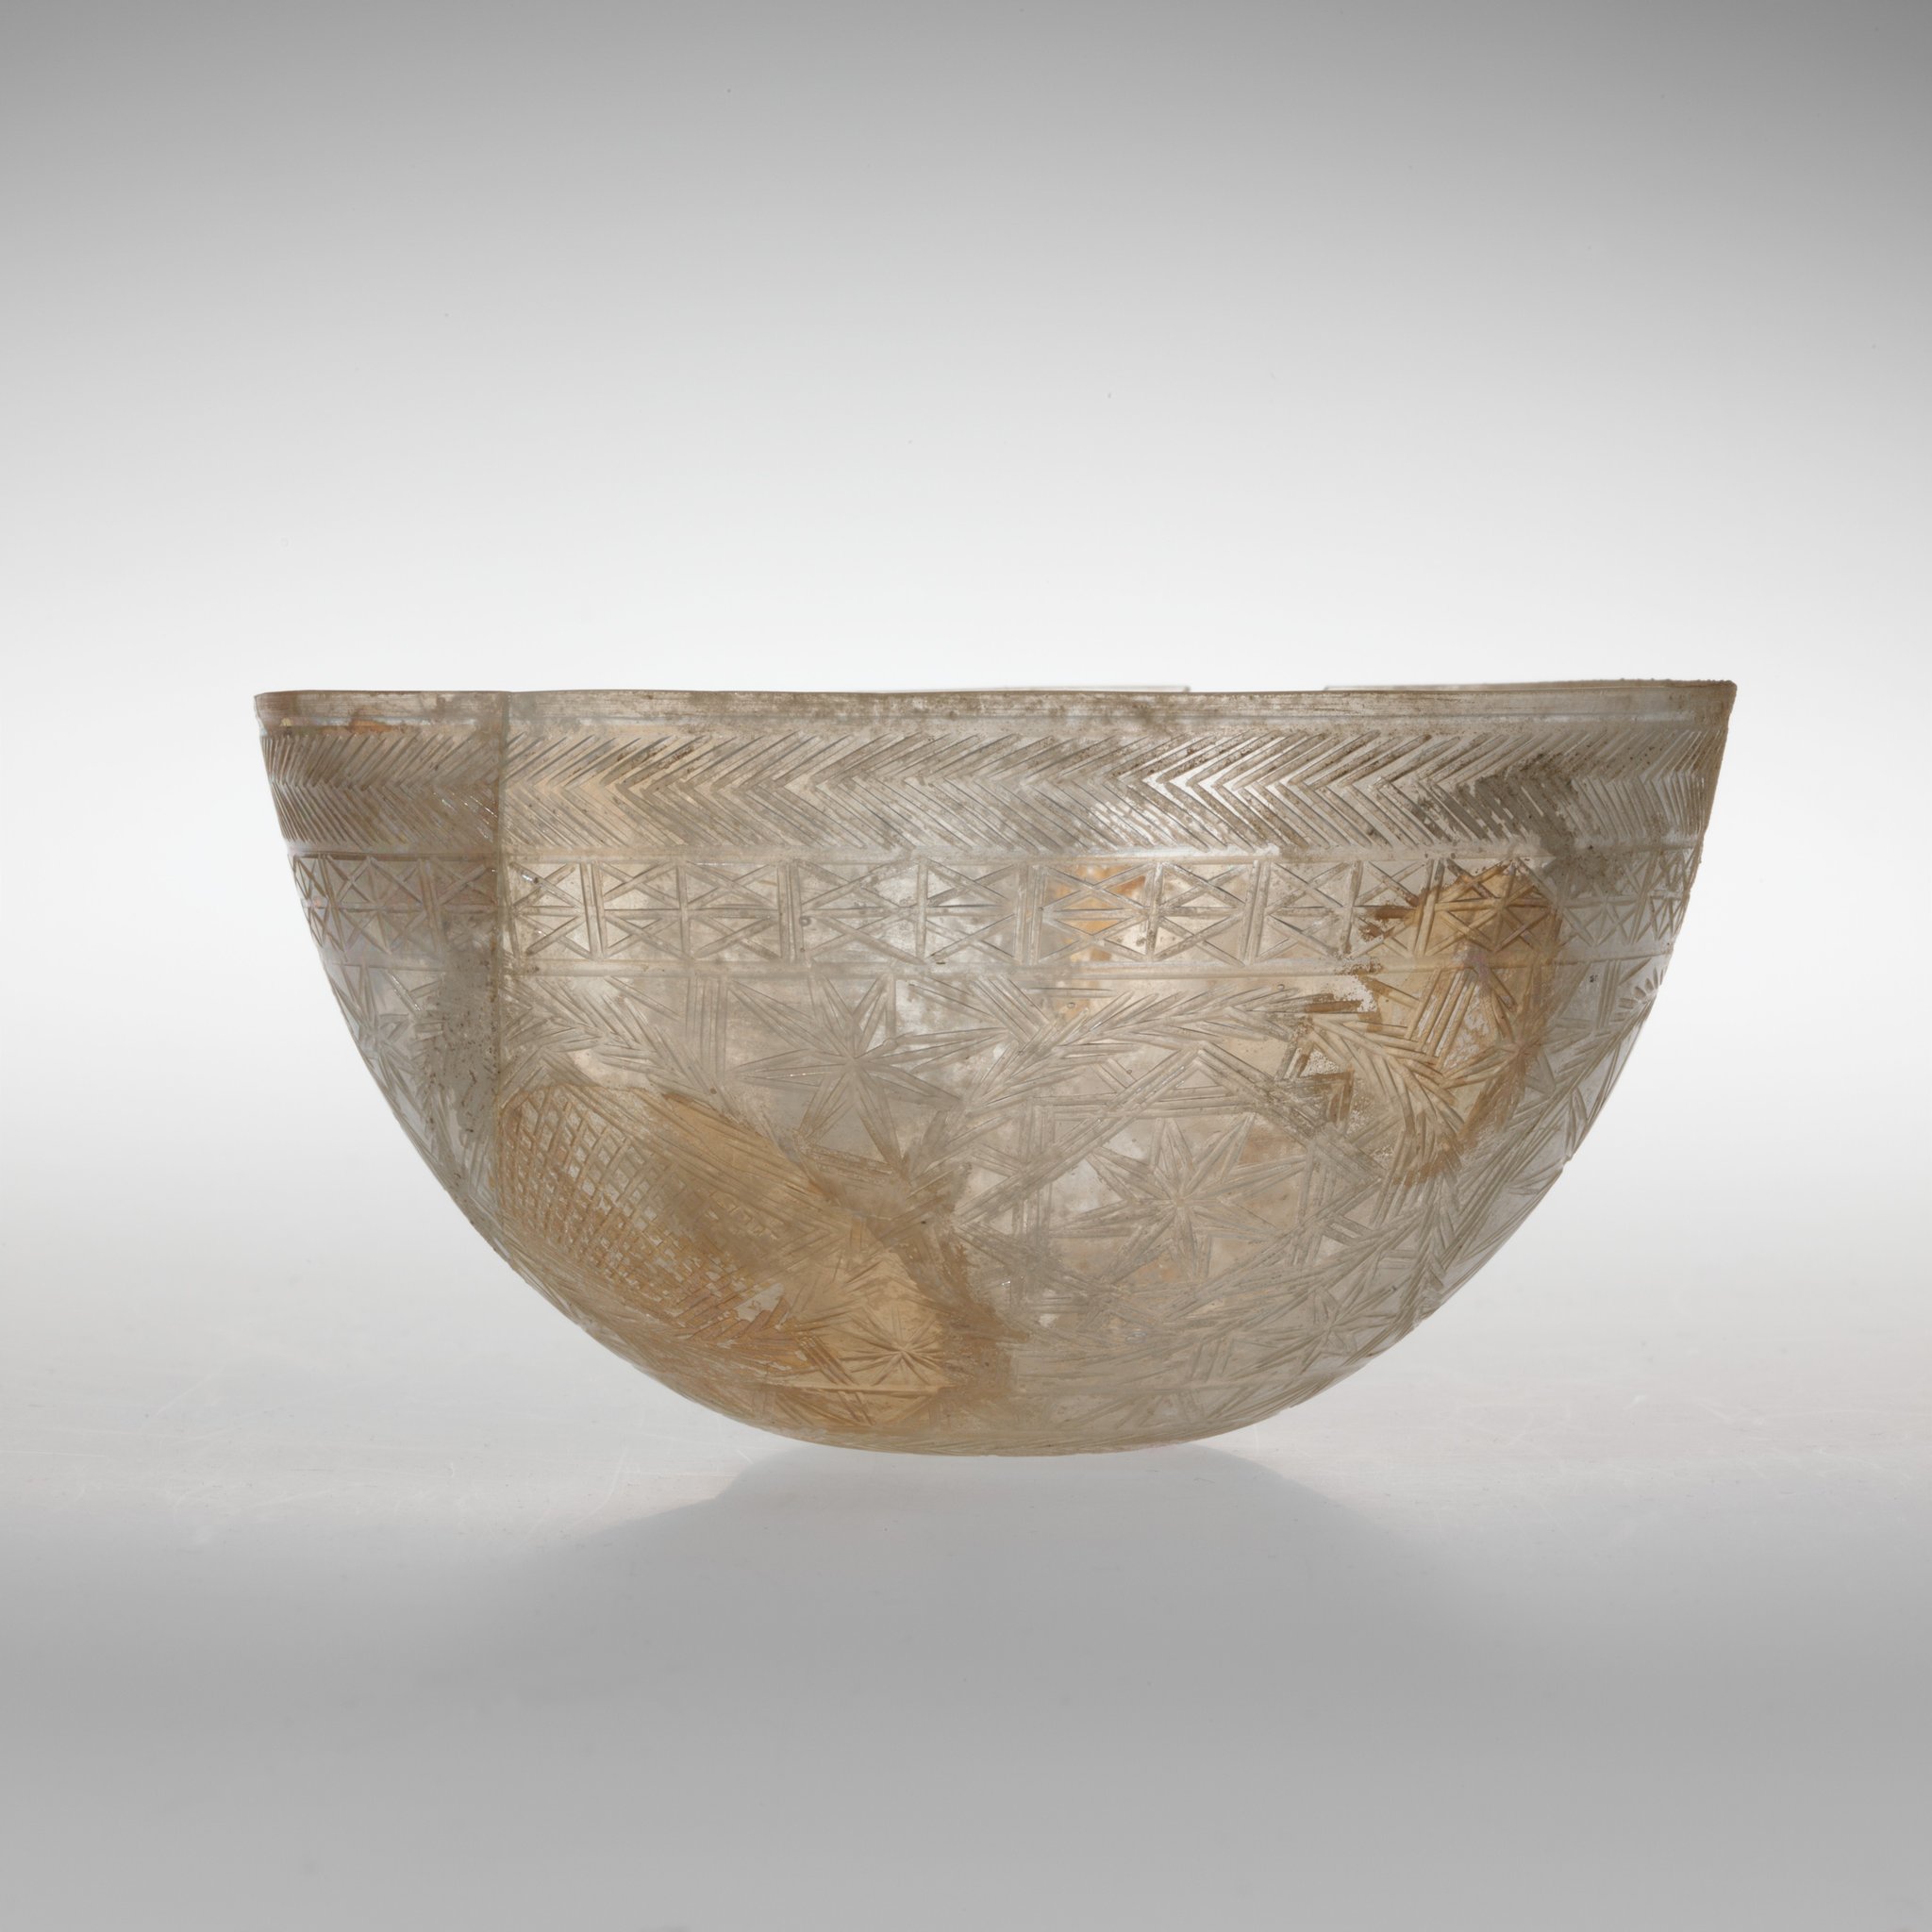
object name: bowl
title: Glass bowl decorated with geometric patterns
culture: roman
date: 301-400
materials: glass